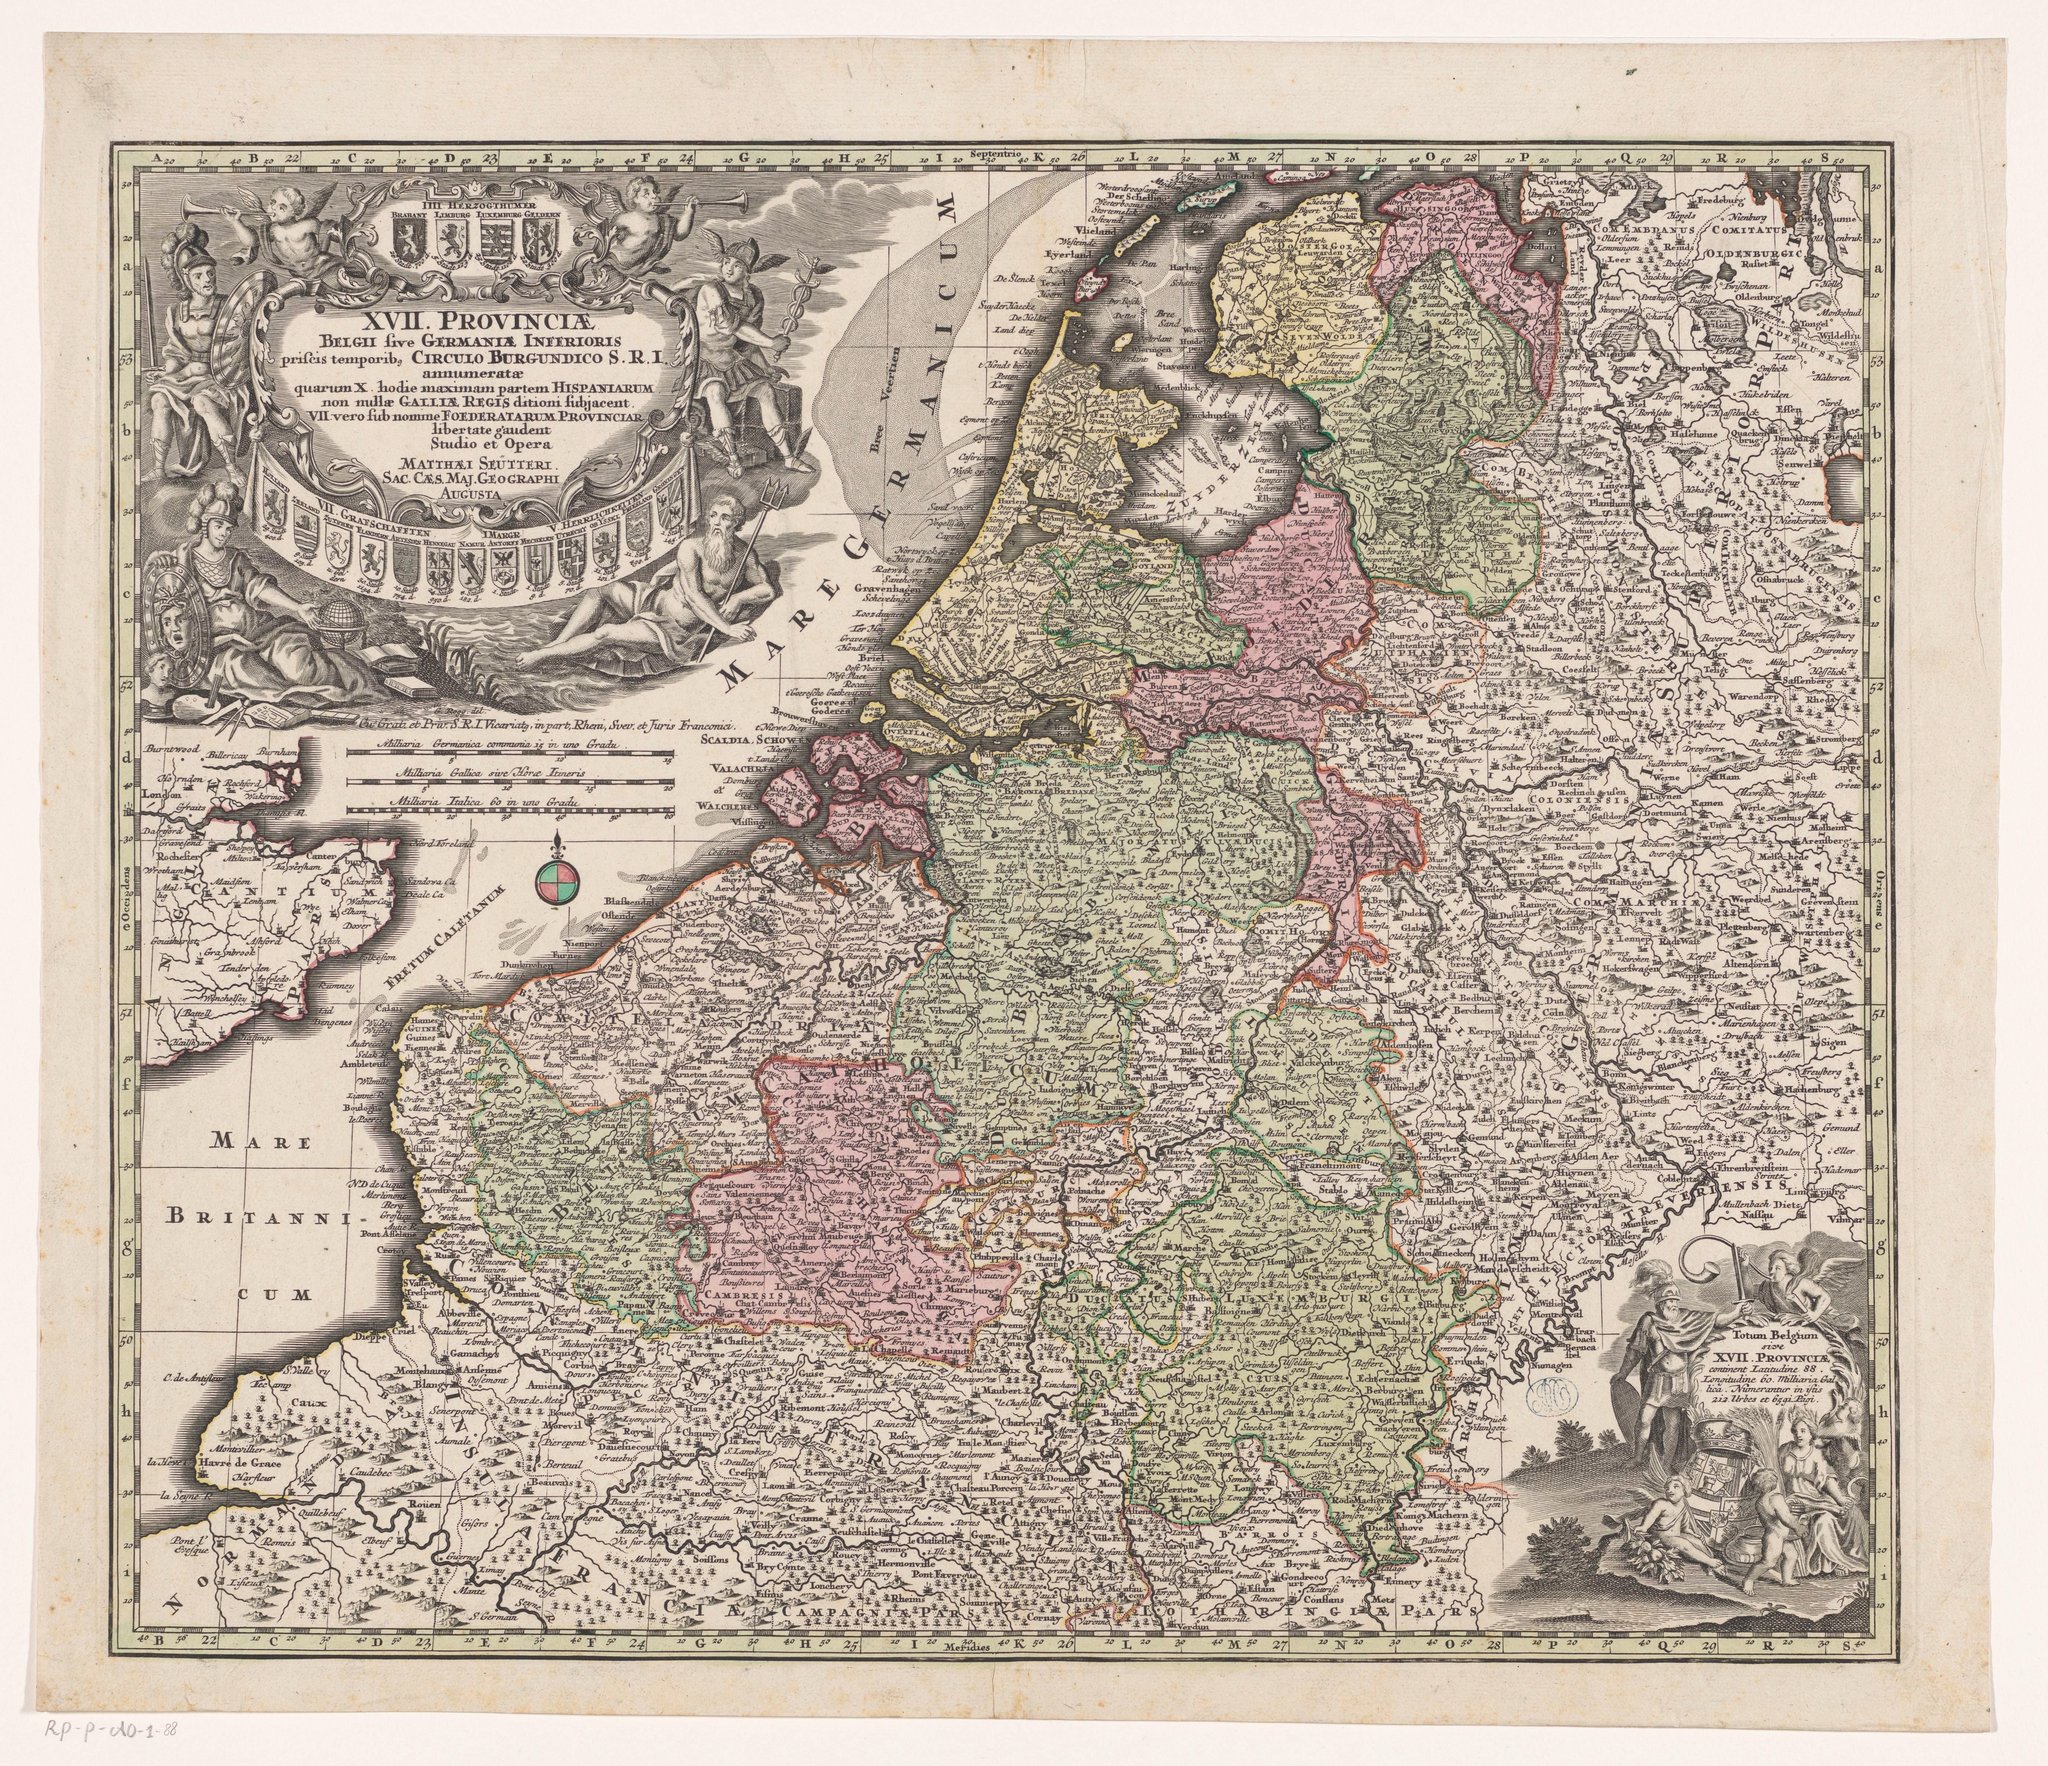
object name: print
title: Kaart van de Zeventien Provinciën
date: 1740-1757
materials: paper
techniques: engraving, hand coloring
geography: augsburg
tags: (story of) neptune (poseidon), coat of arms (as symbol of the state, etc.), (story of) ceres (demeter), (story of) mars (ares), maps of separate countries or regions, (story of) minerva (pallas, athena), (story of) mercury (hermes), fame; 'fama', 'fama buona', 'fama chiara' (ripa), low countries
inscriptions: collector's mark: Lugt 2228, collector's mark: Lugt 195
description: Rechtsboven titelcartouche met daaromheen de wapens van de Zeventien Provinciën, twee putti met een bazuin, Mars, Mercurius, Neptunus en Minerva. Daaronder schaalstok: Milliaria Germanica communia 15 in uno gradu, Milliaria Gallica sive horae itineris, Milliaria Italica 60 in uno gradu. Linksonder cartouche met daaromheen Mars, Fama, Ceres en een aantal putti. De kaart is voorzien van een zoekrooster en een gradenverdeling langs de randen.